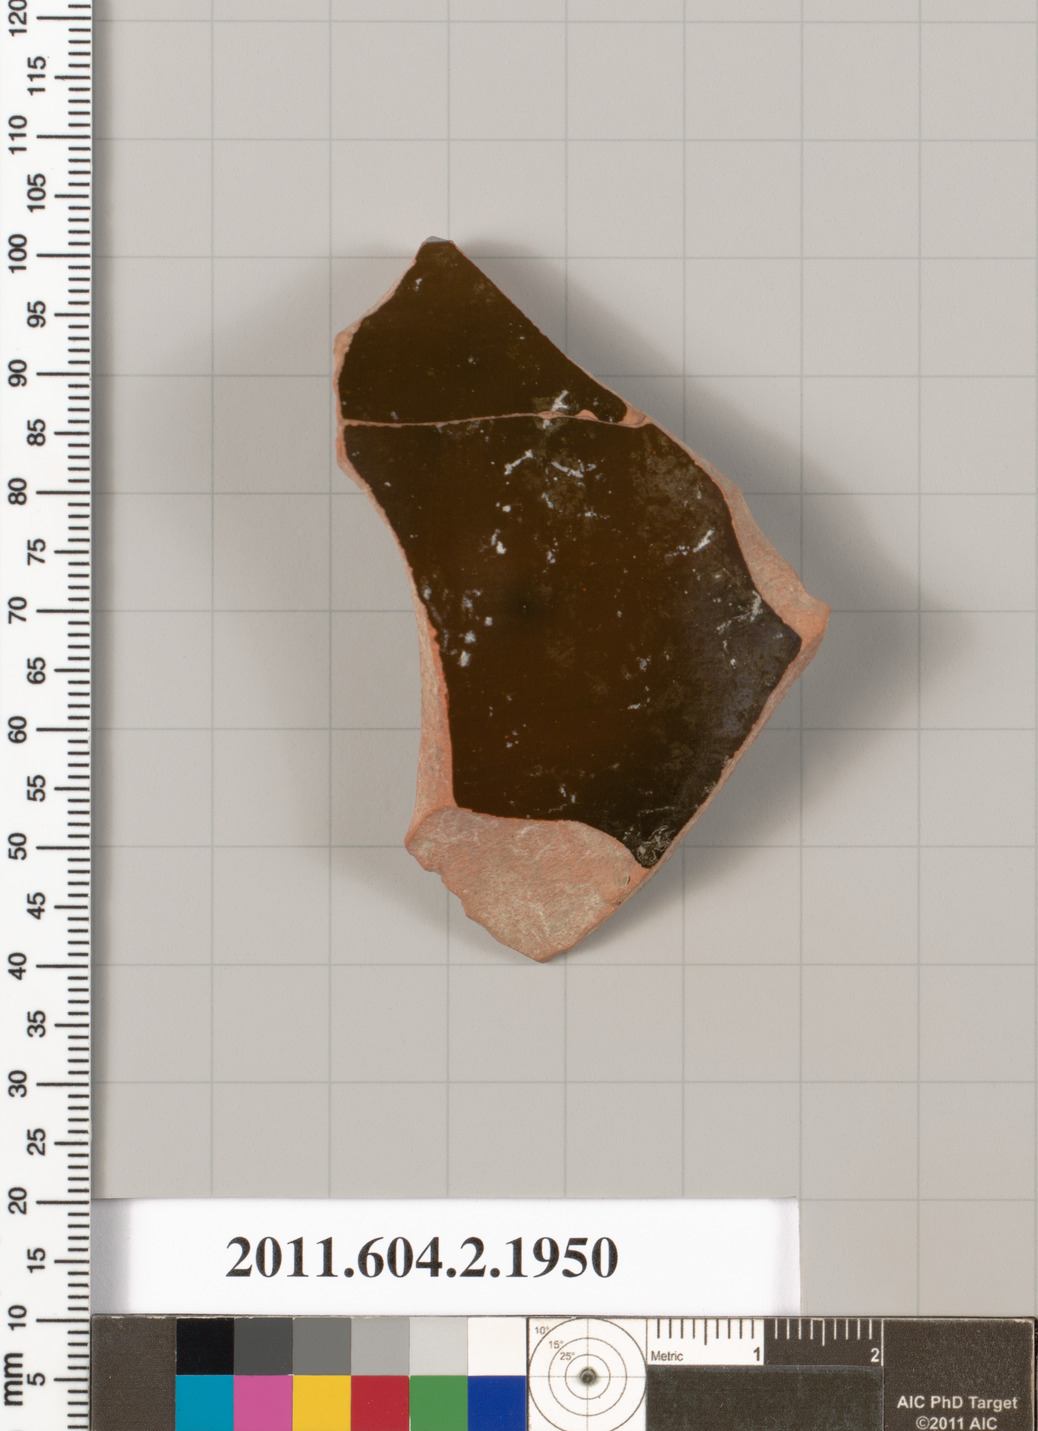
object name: neck amphora fragment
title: Terracotta fragment of a Nolan neck-amphora (jar)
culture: greek, attic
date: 475-460 BCE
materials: terracotta